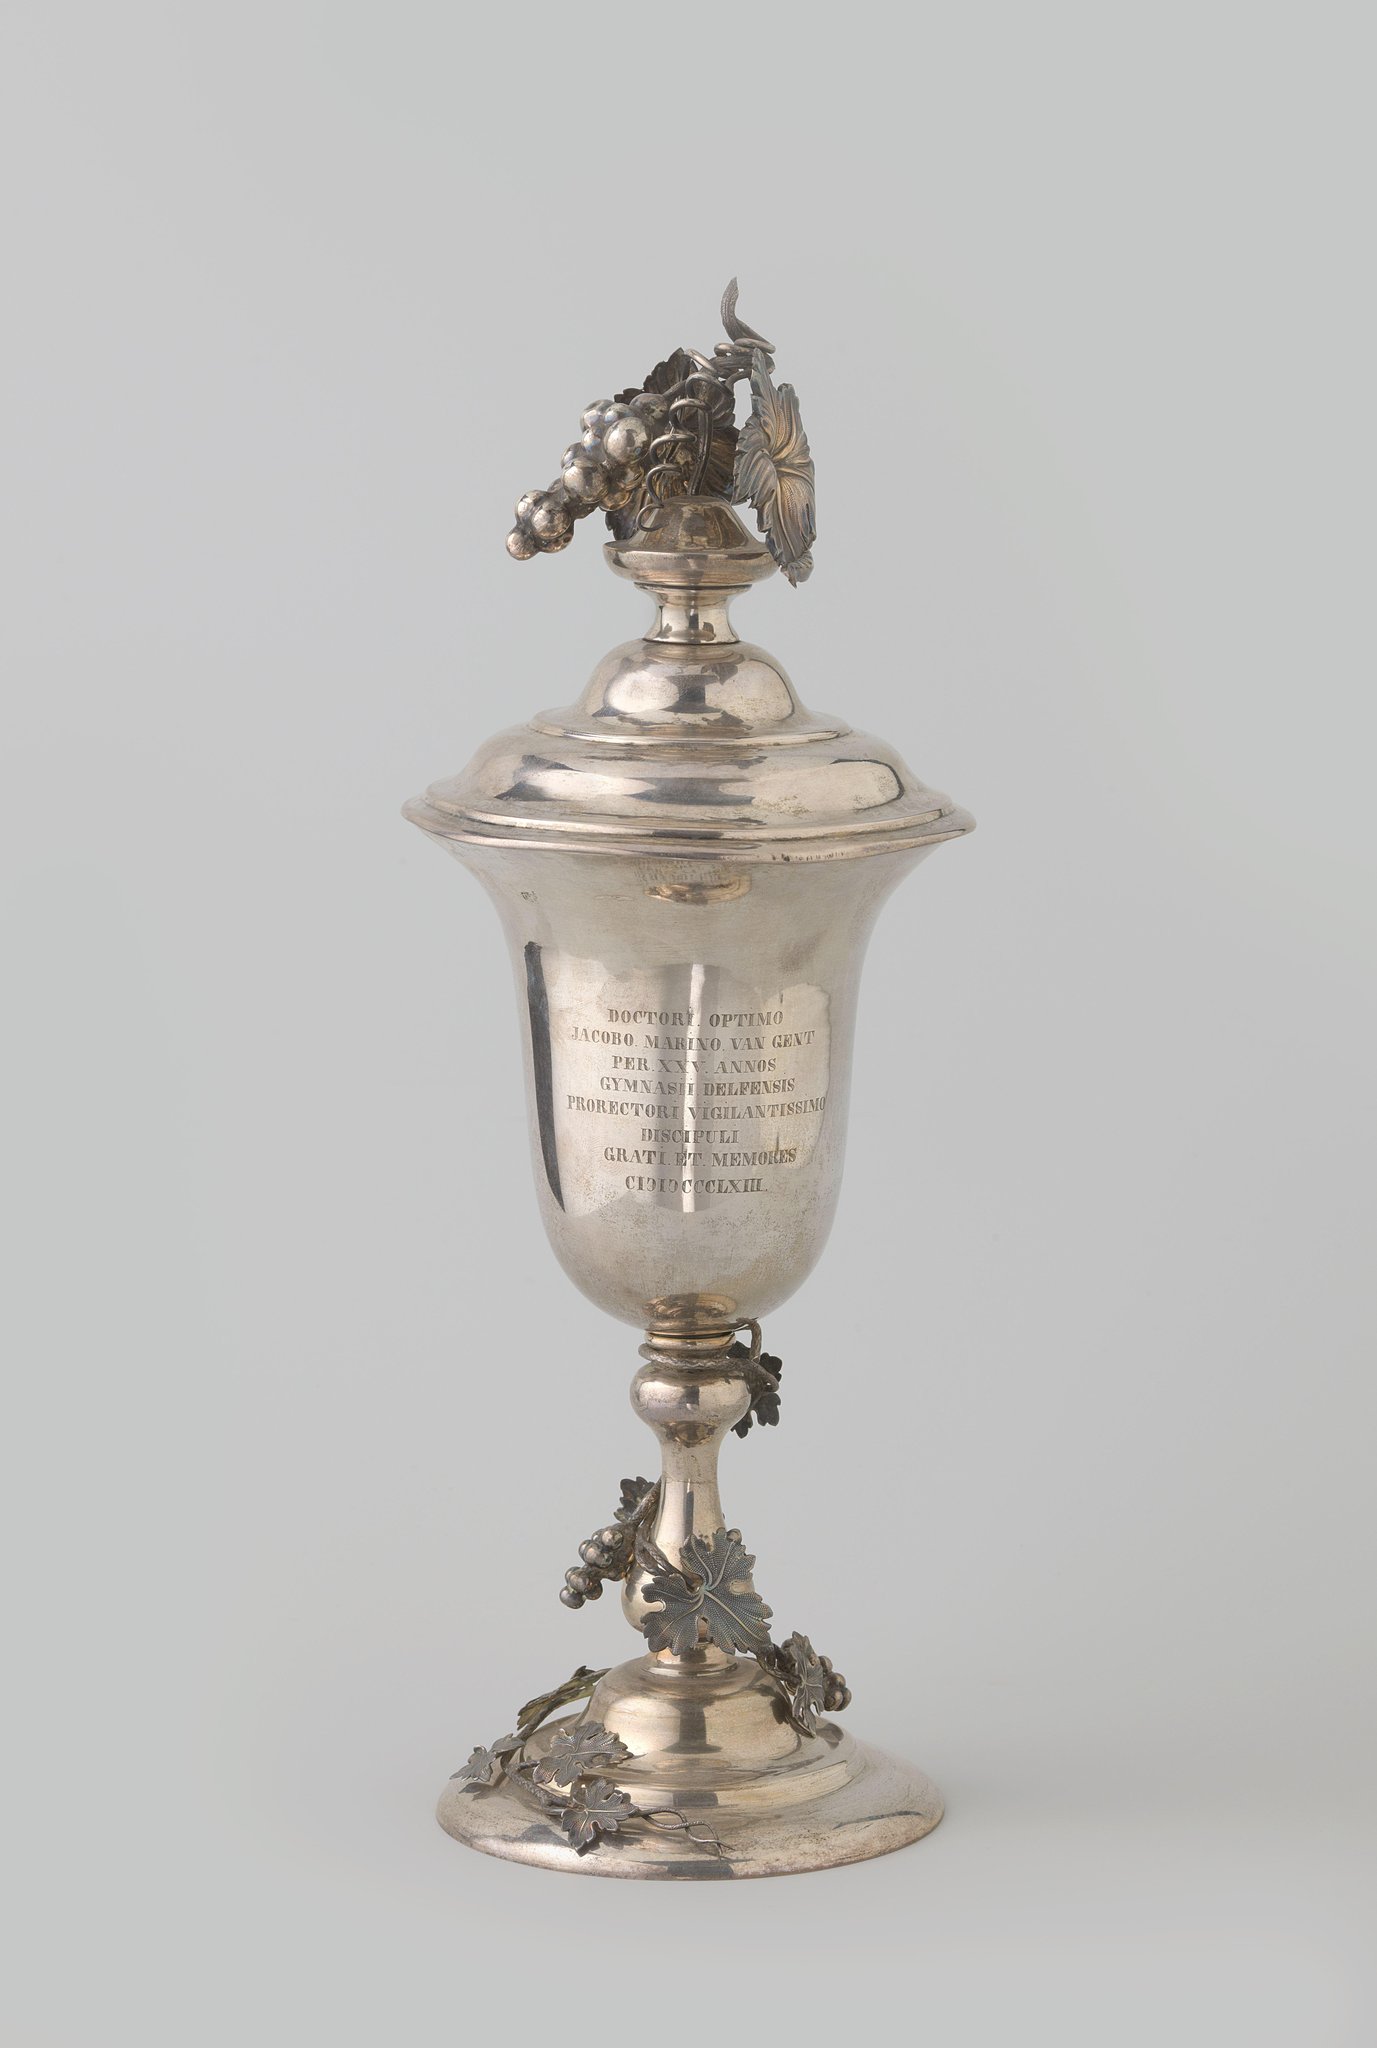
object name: goblet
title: Bokaal met deksel van zilver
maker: c.e. jedeloo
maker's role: silversmith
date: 1863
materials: silver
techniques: gilding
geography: delft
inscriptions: mark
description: Beker met deksel van zilver, van binnen verguld. Versierd met druivenranken om de voet en op het deksel.